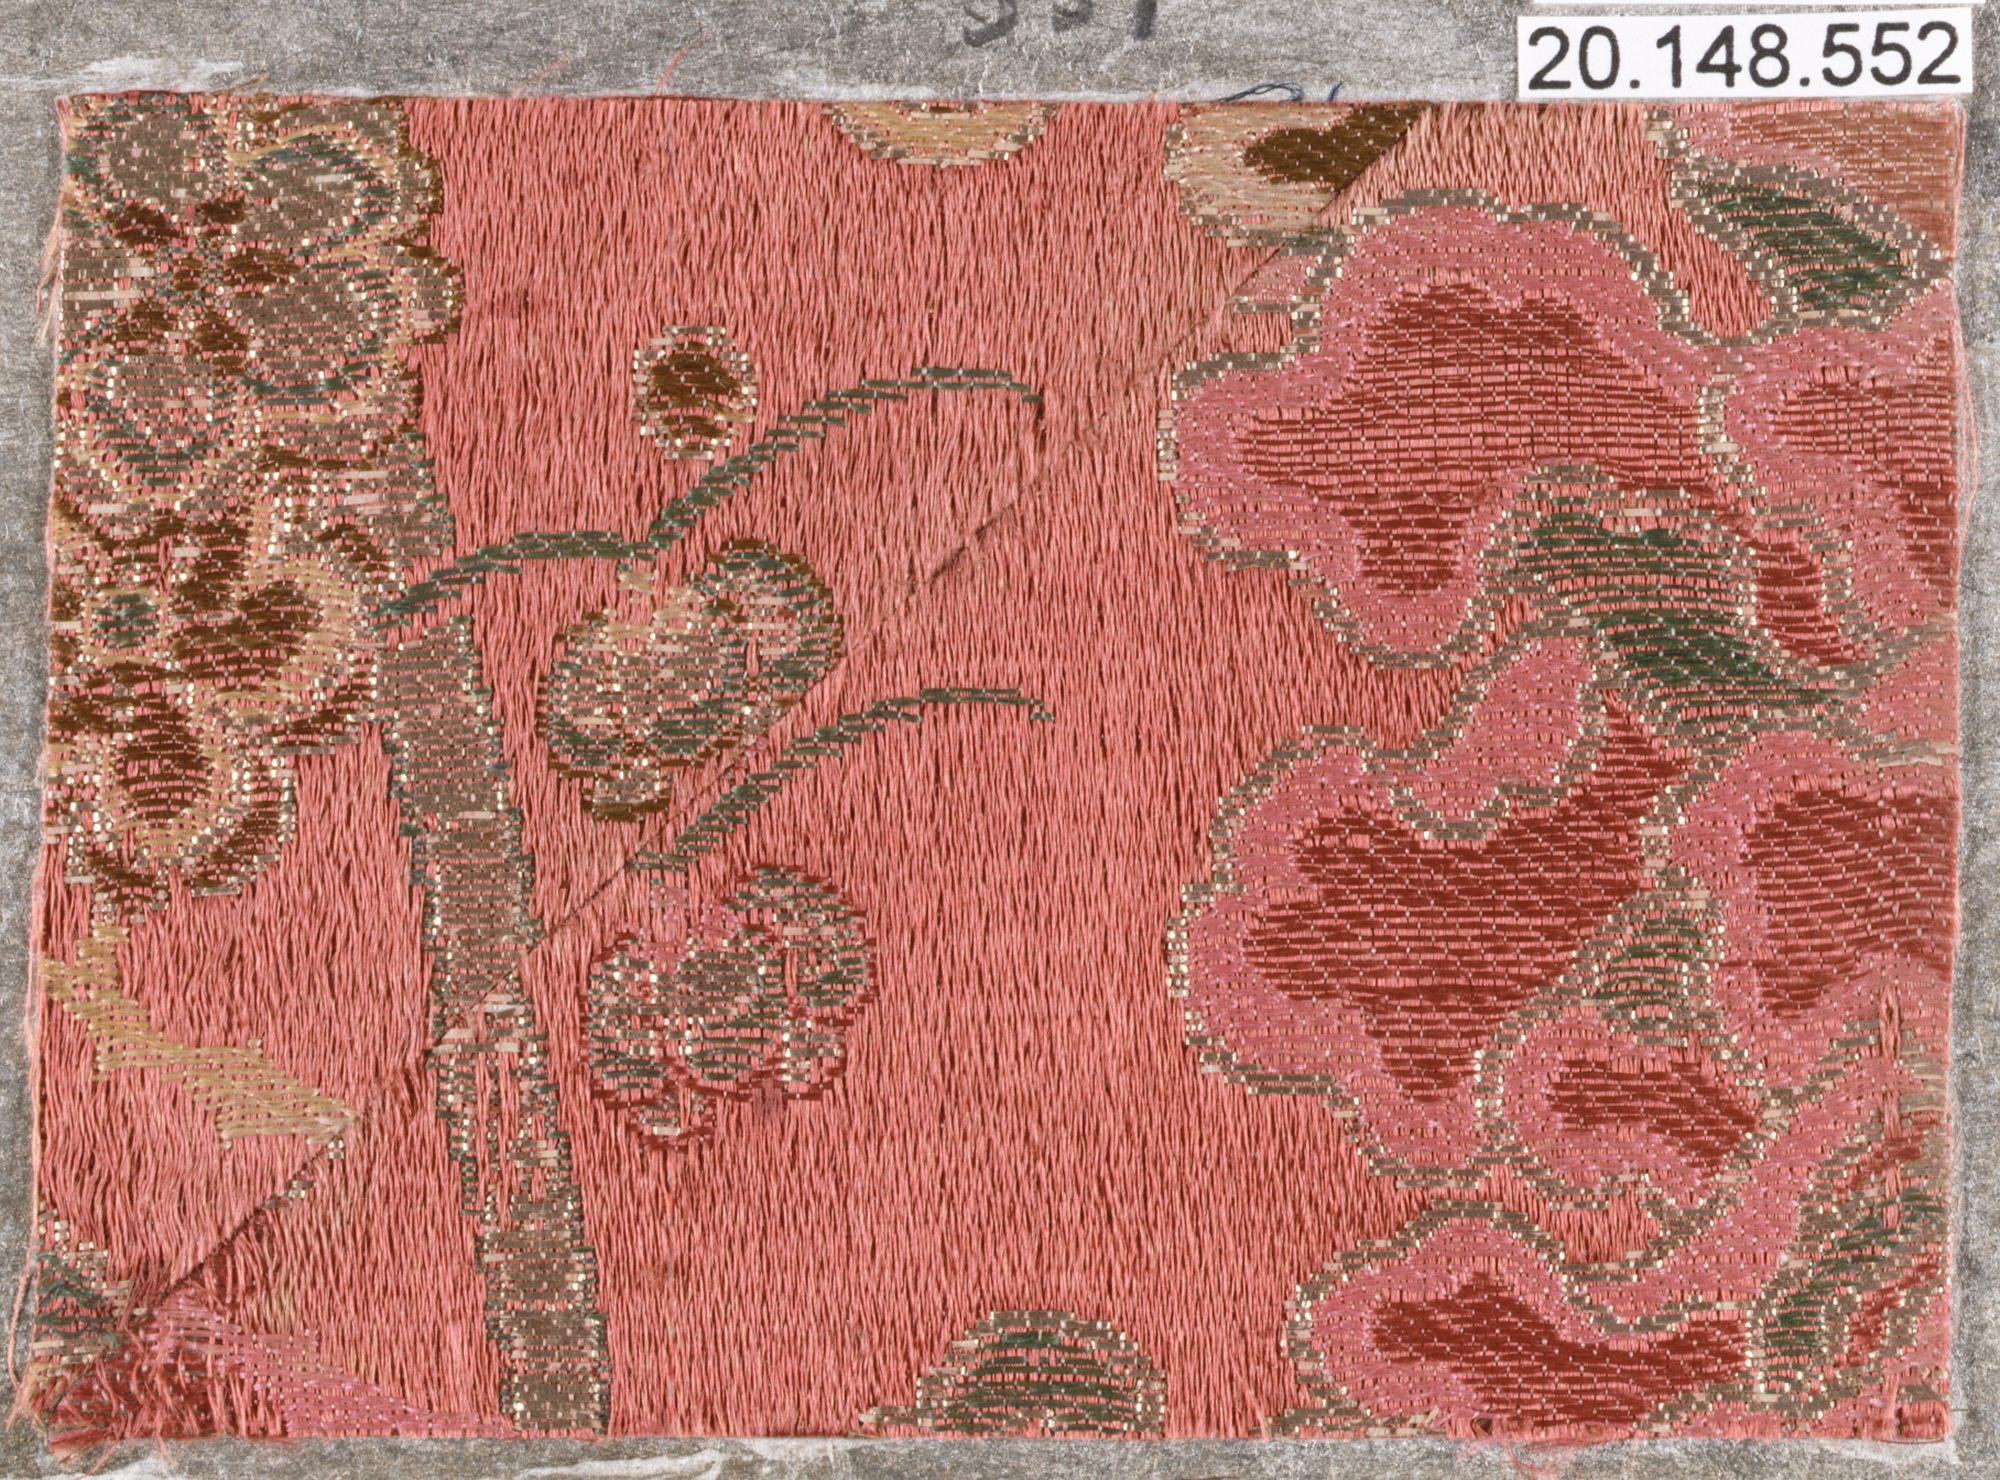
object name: piece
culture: chinese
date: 1701-1800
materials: silk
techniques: compound weave